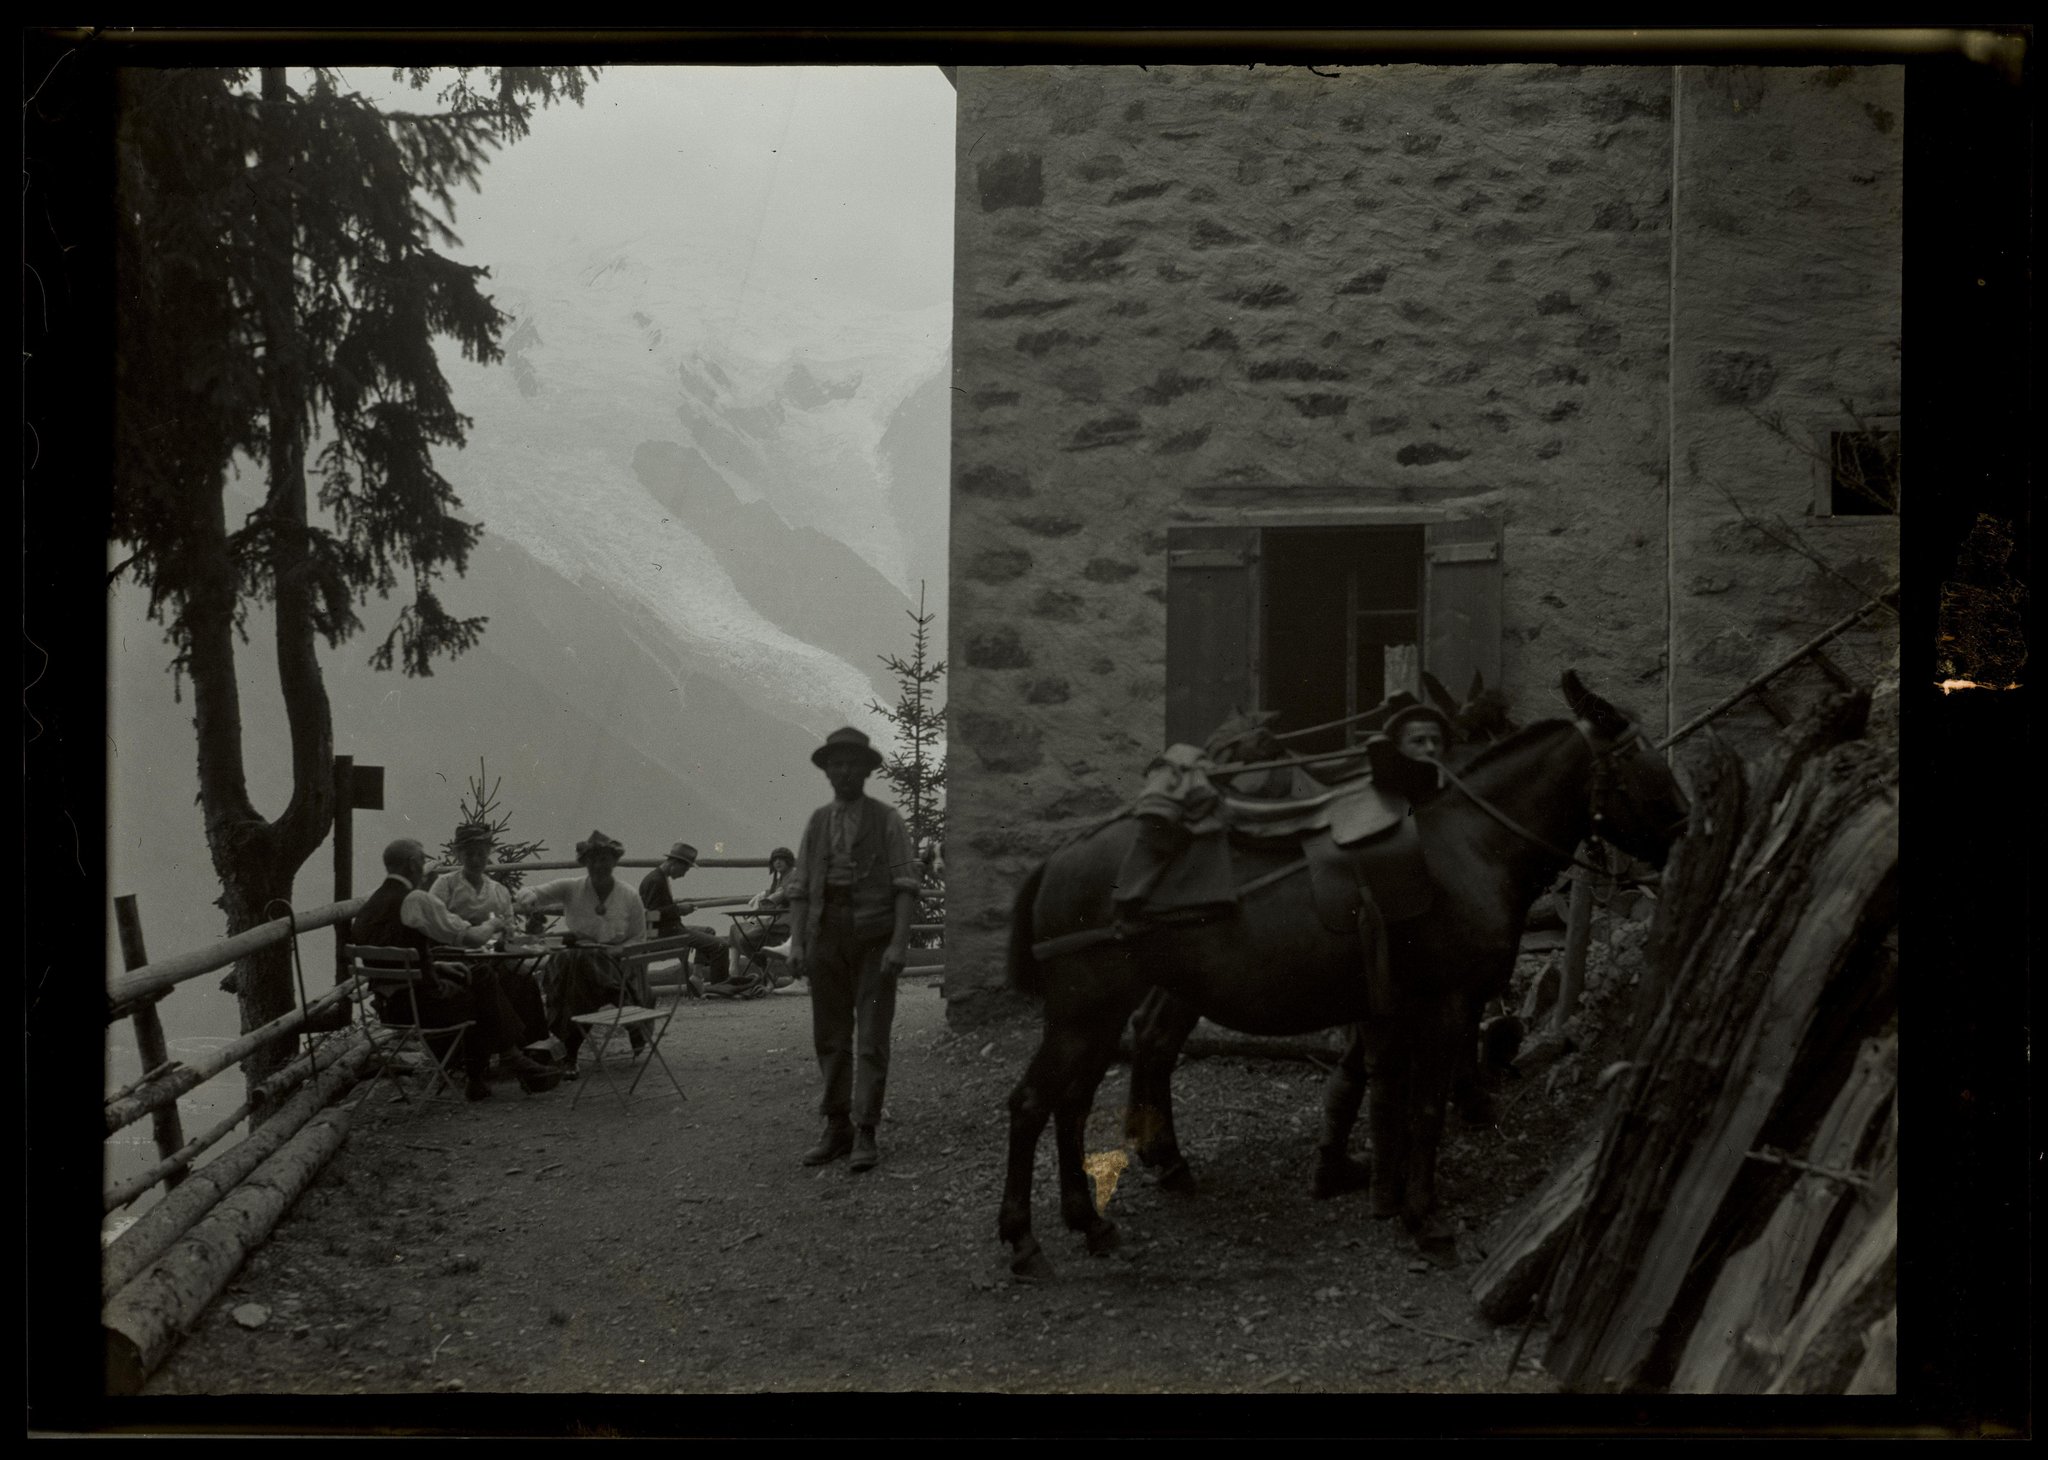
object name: negative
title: Negatief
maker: Anonymous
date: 1907-1935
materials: film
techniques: gelatin silver negative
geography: netherlands